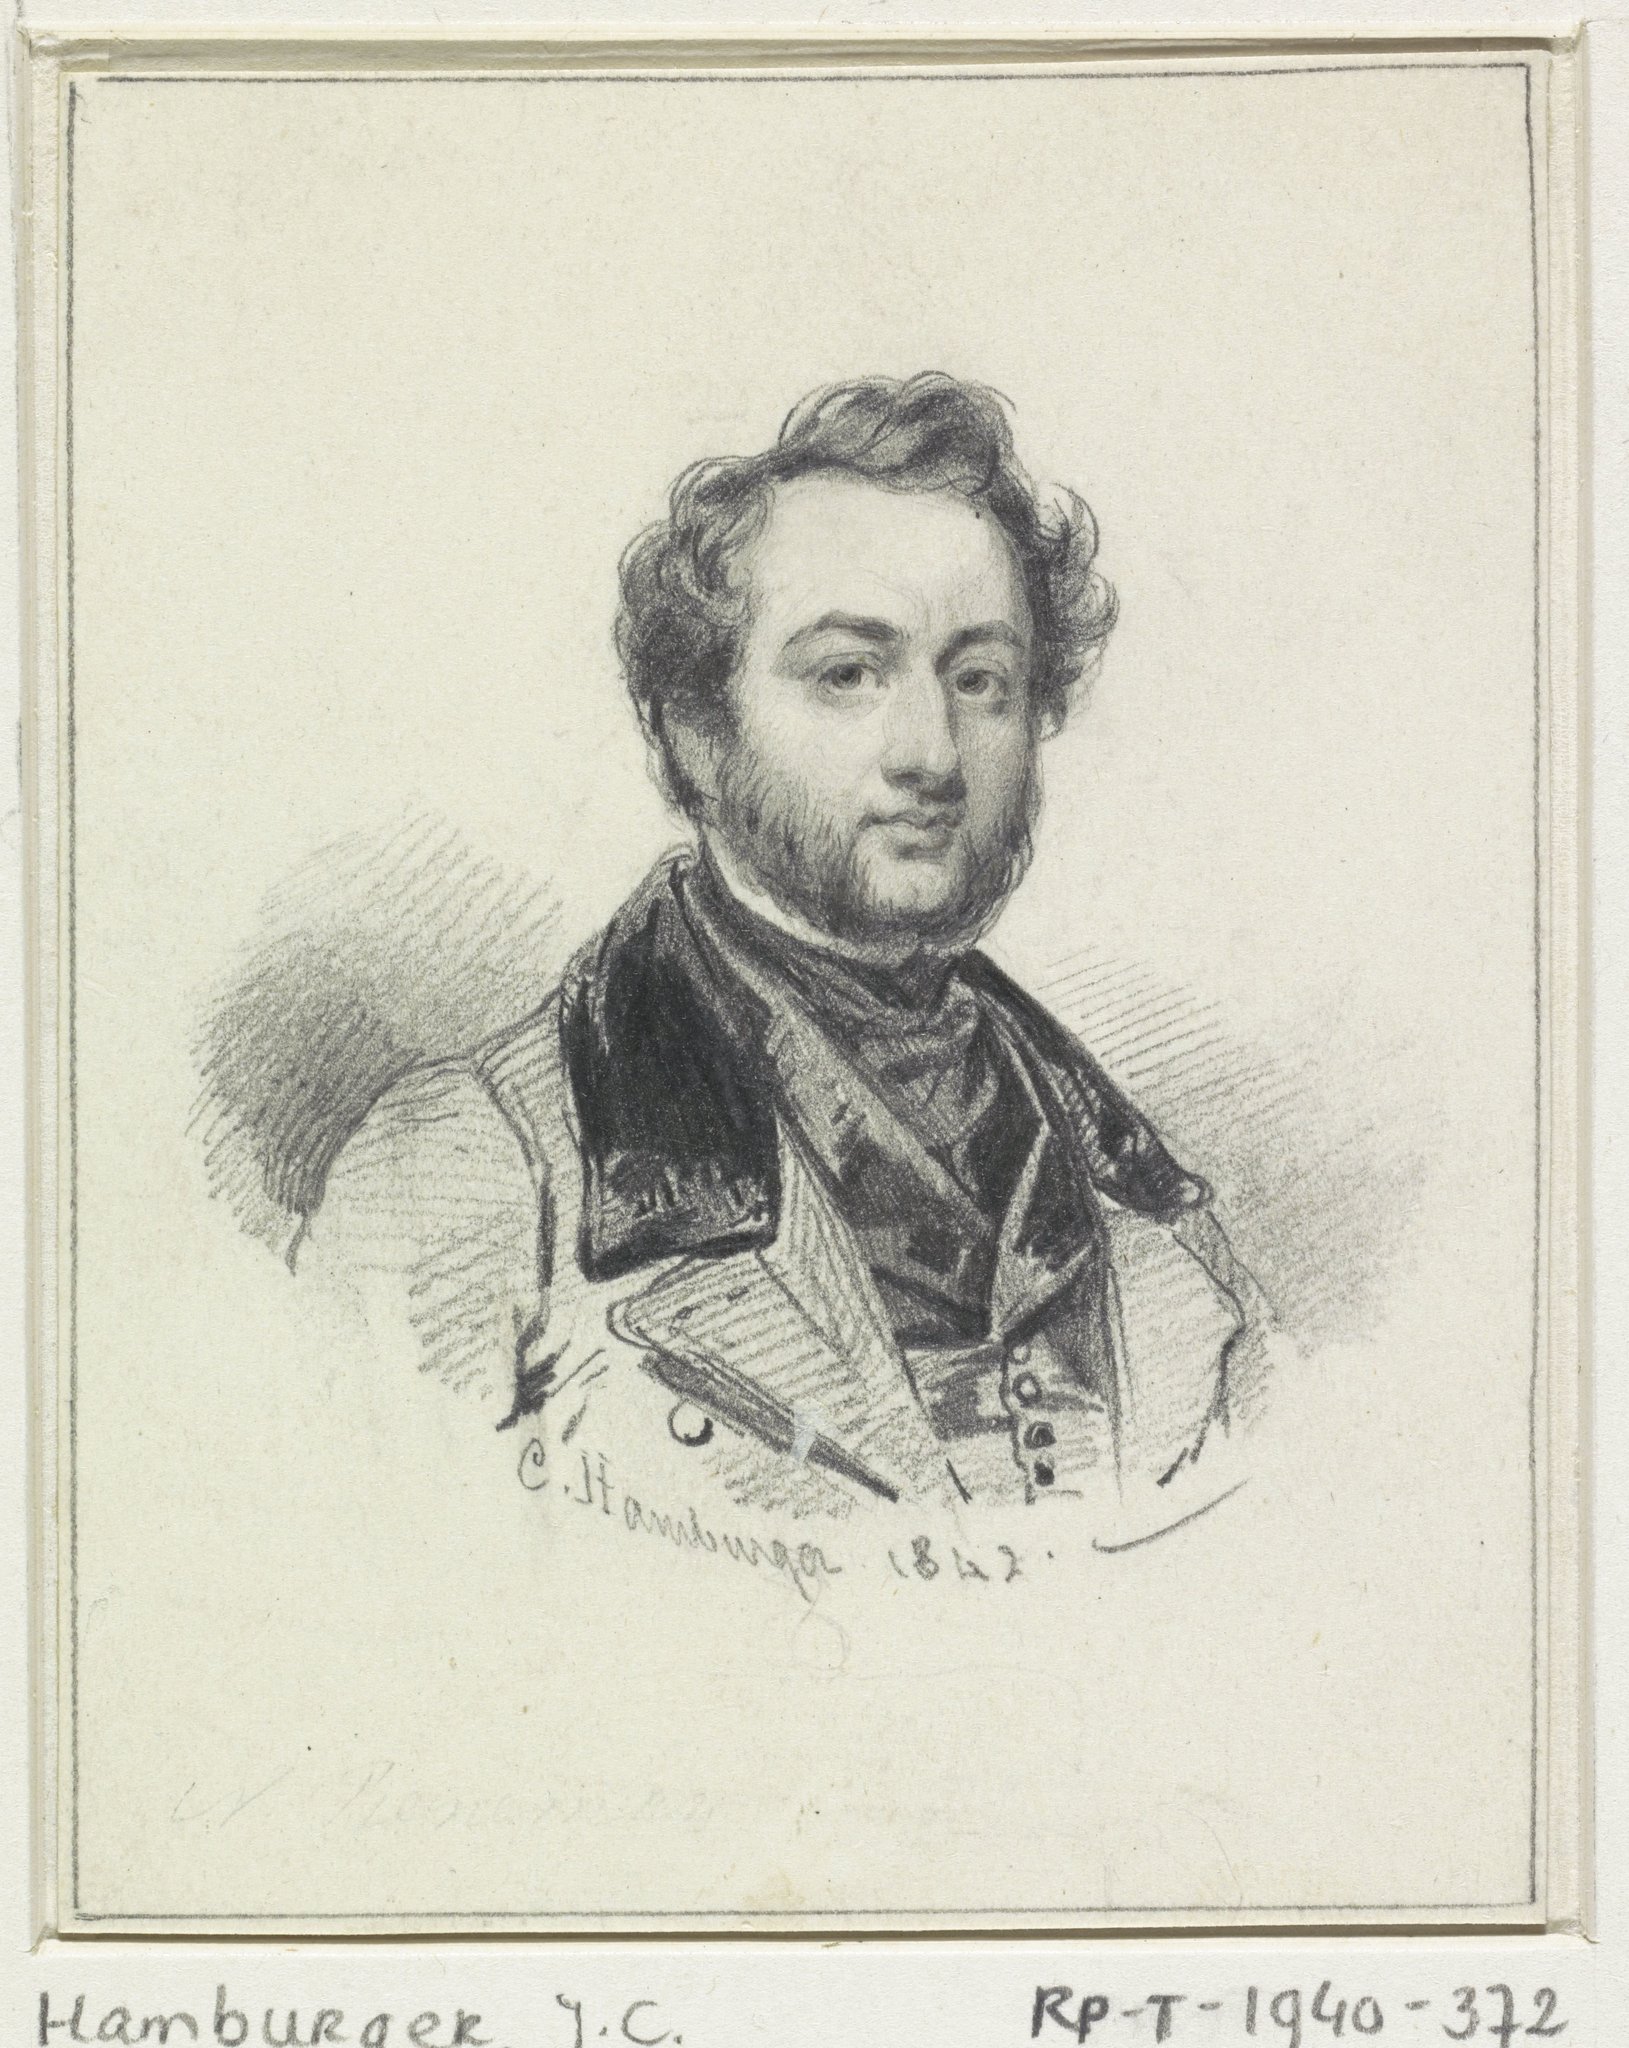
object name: drawing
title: Portret van Nicolaas Pieneman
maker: coenraad hamburger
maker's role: draughtsman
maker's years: 1809-1891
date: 1842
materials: paper, pencil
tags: amsterdam, nicolaas pieneman, historical persons, portrait, self-portrait of painter, portrait, self-portrait of artist